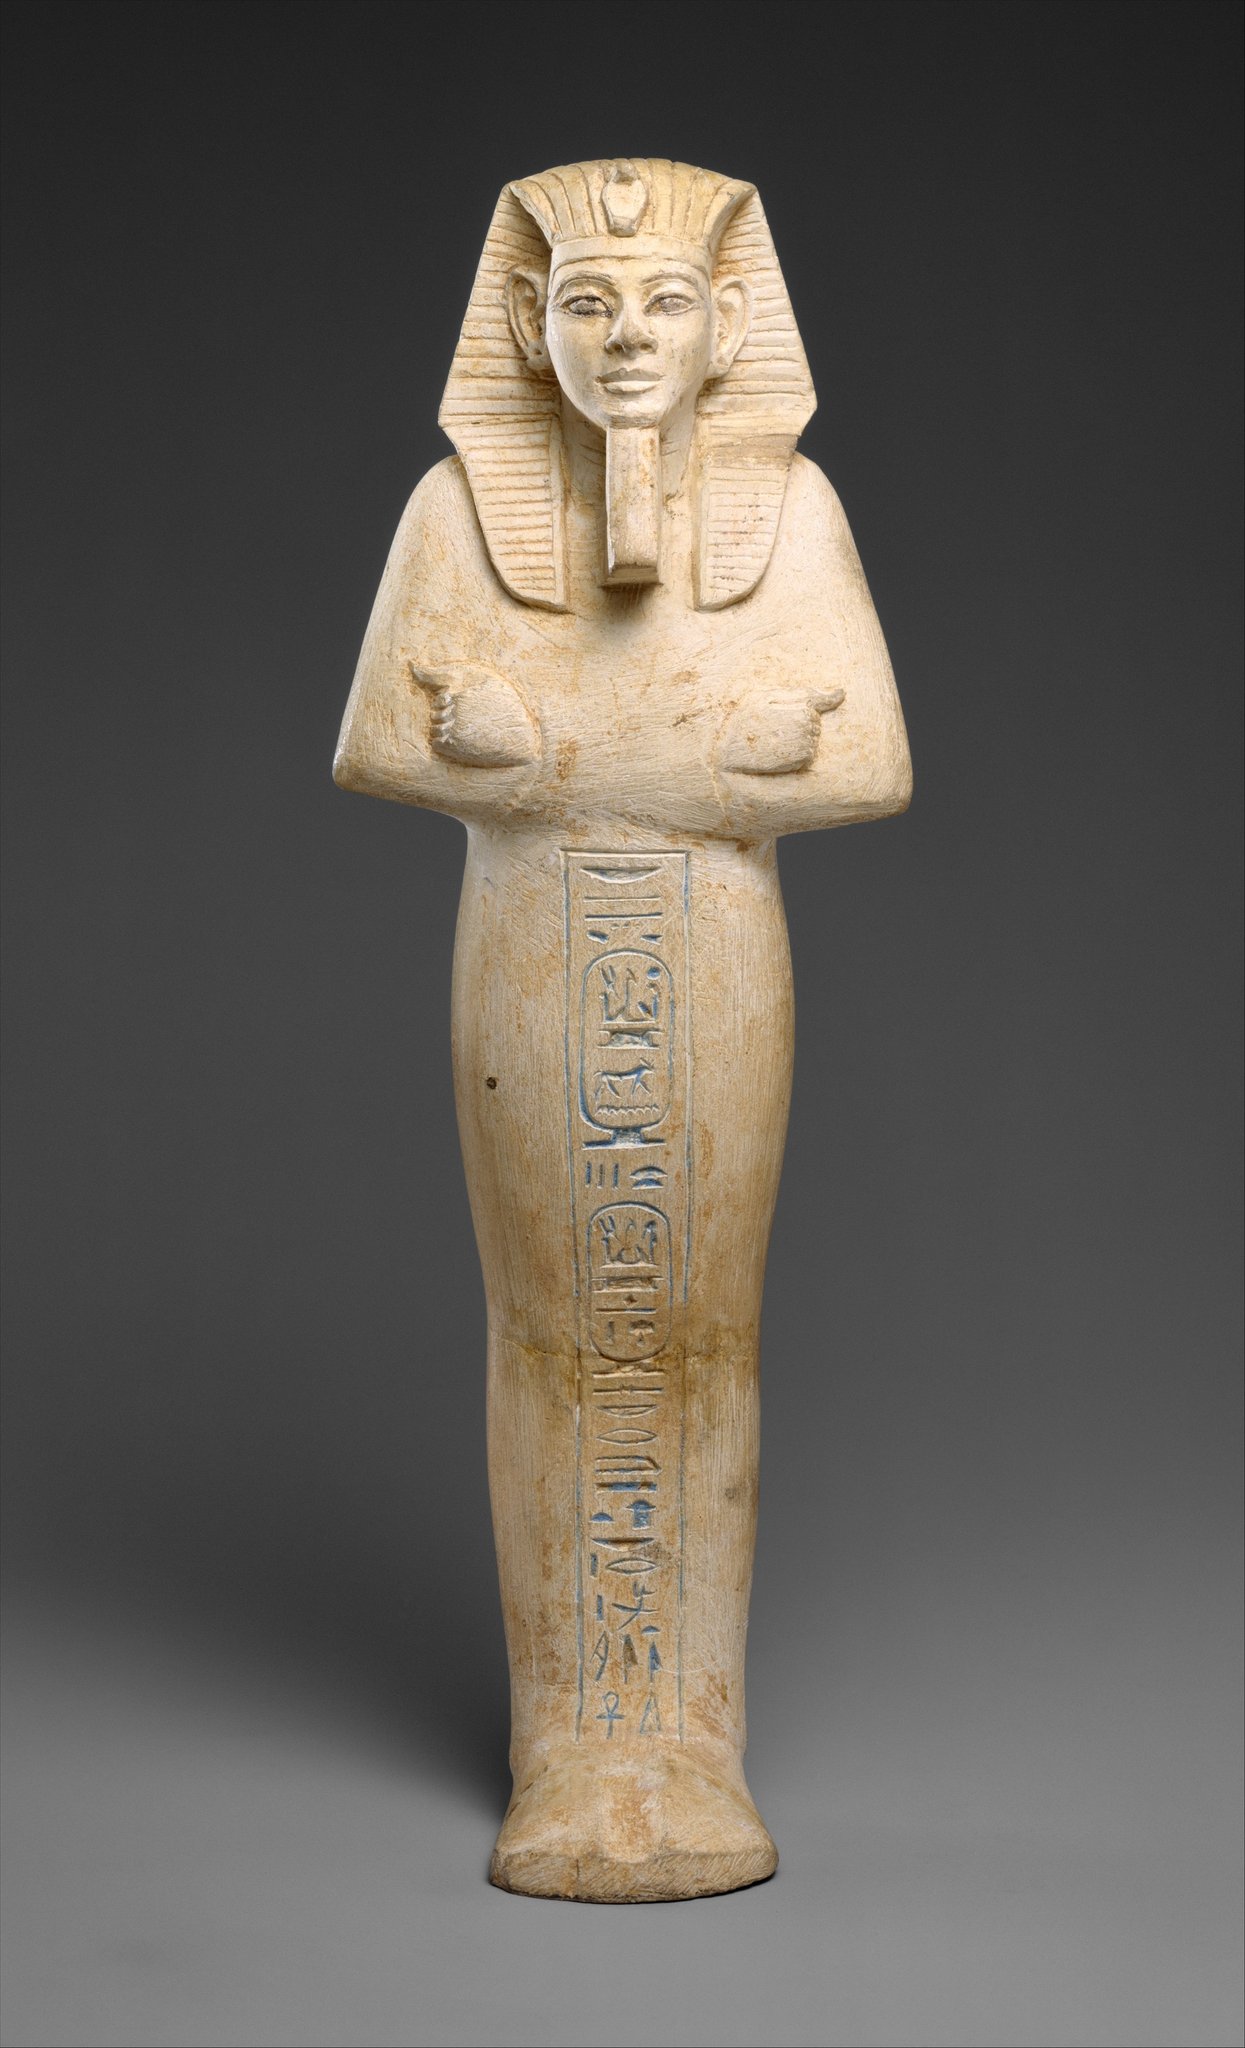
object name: shabti, merneptah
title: Shabti of Merneptah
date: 1213-1203 BCE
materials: limestone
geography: upper egypt, thebes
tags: hieroglyphs